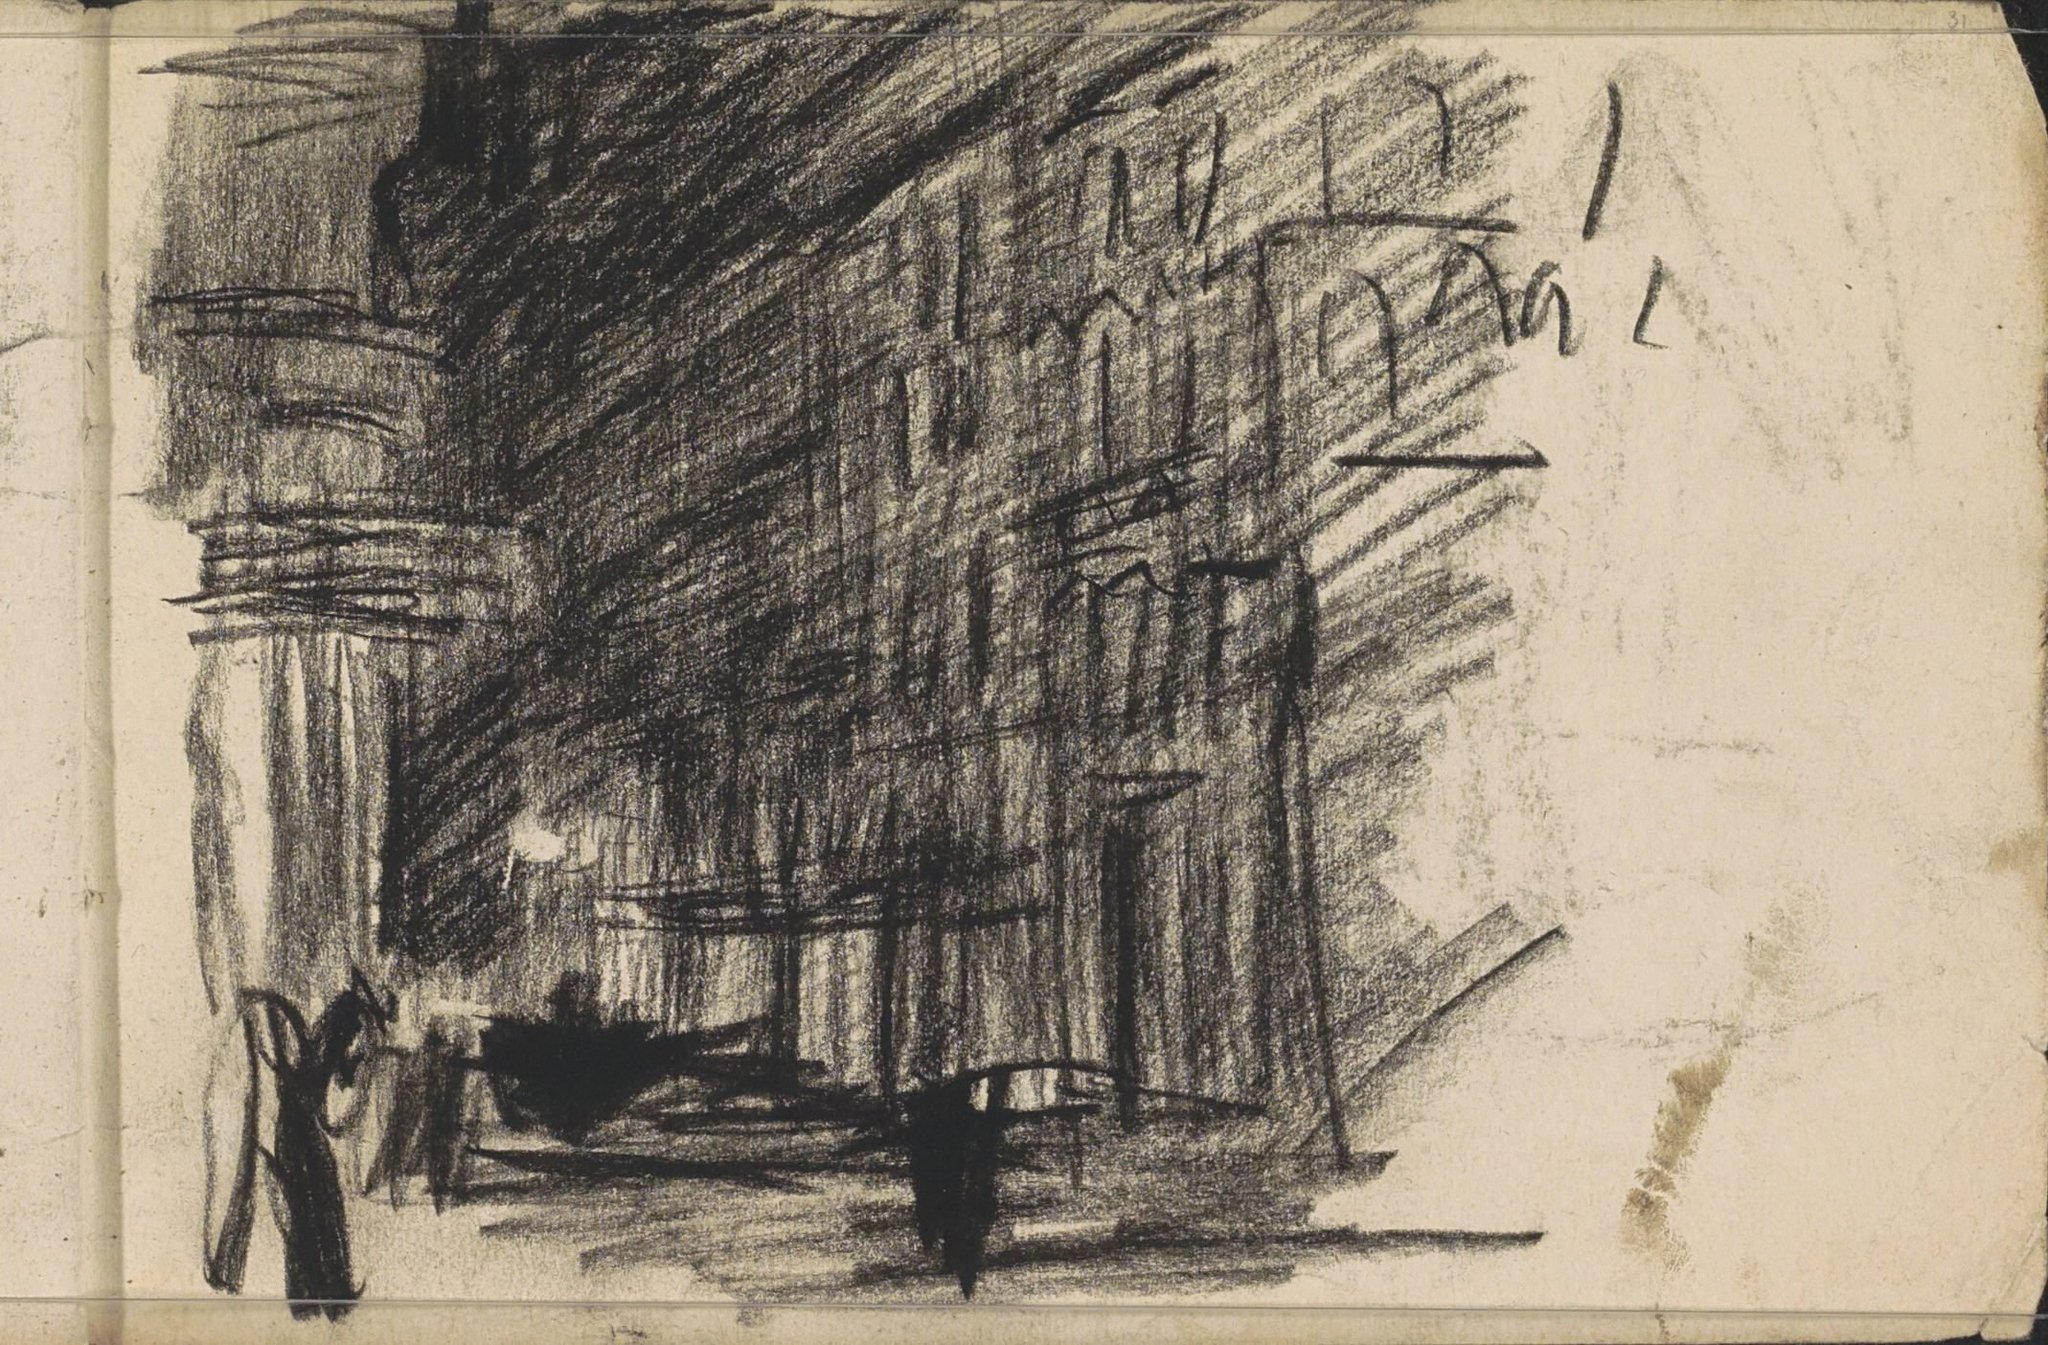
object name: sketchbook leaf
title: Straatgezicht bij avond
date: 1875-1934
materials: chalk, paper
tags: evening, street (+ city(-scape) with figures, staffage), paris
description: Mogelijk in Parijs. Pagina 31 uit schetsboek XLVI met 32 pagina's.